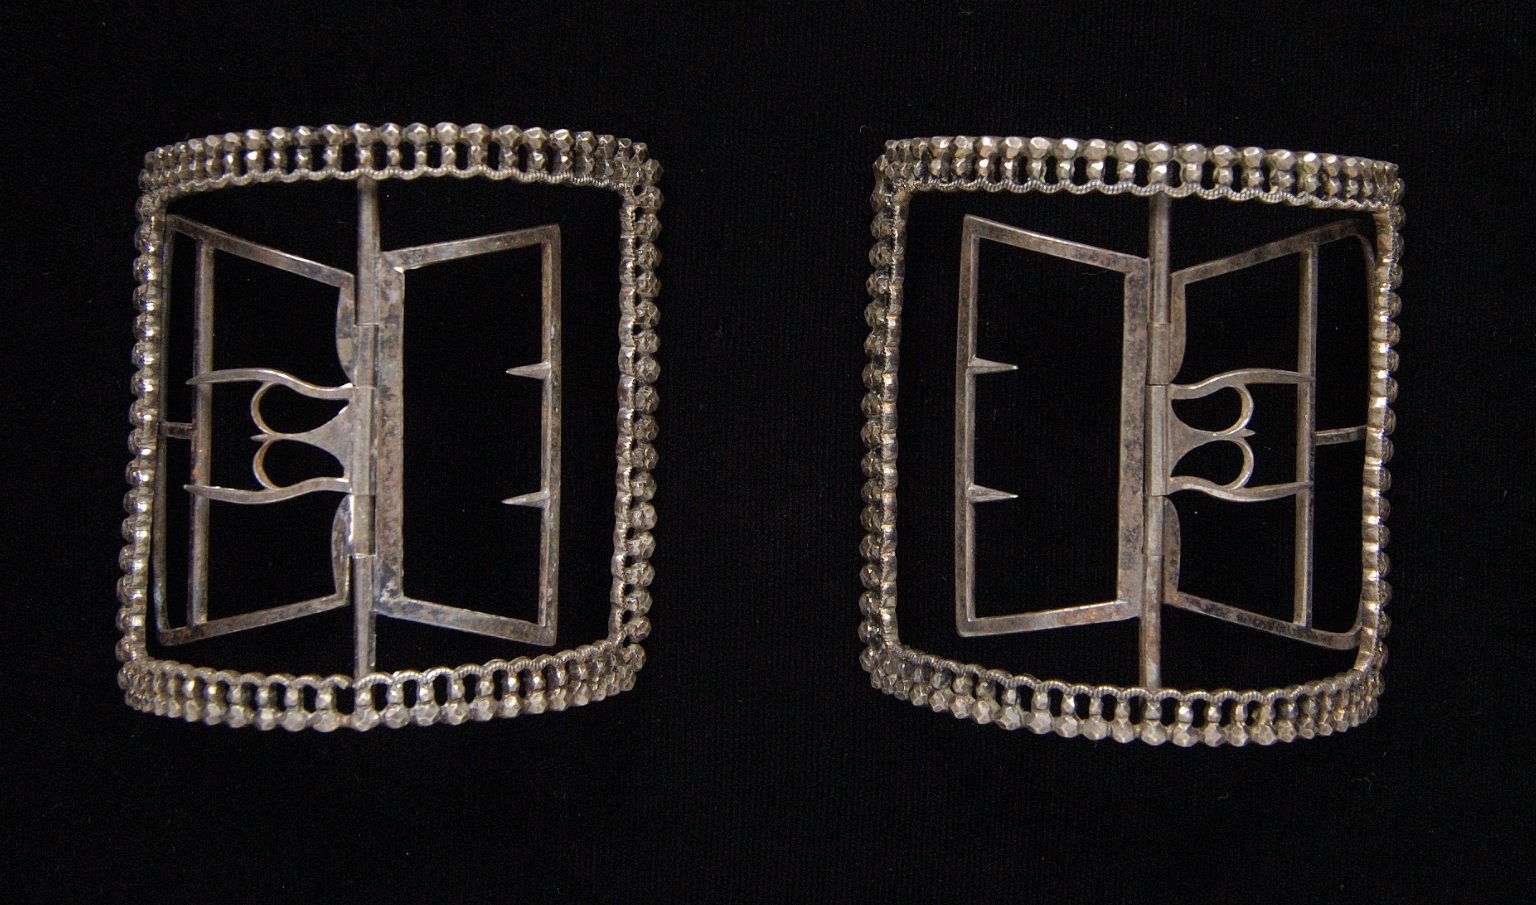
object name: shoe buckle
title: Shoe buckles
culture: british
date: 1770-1780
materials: metal